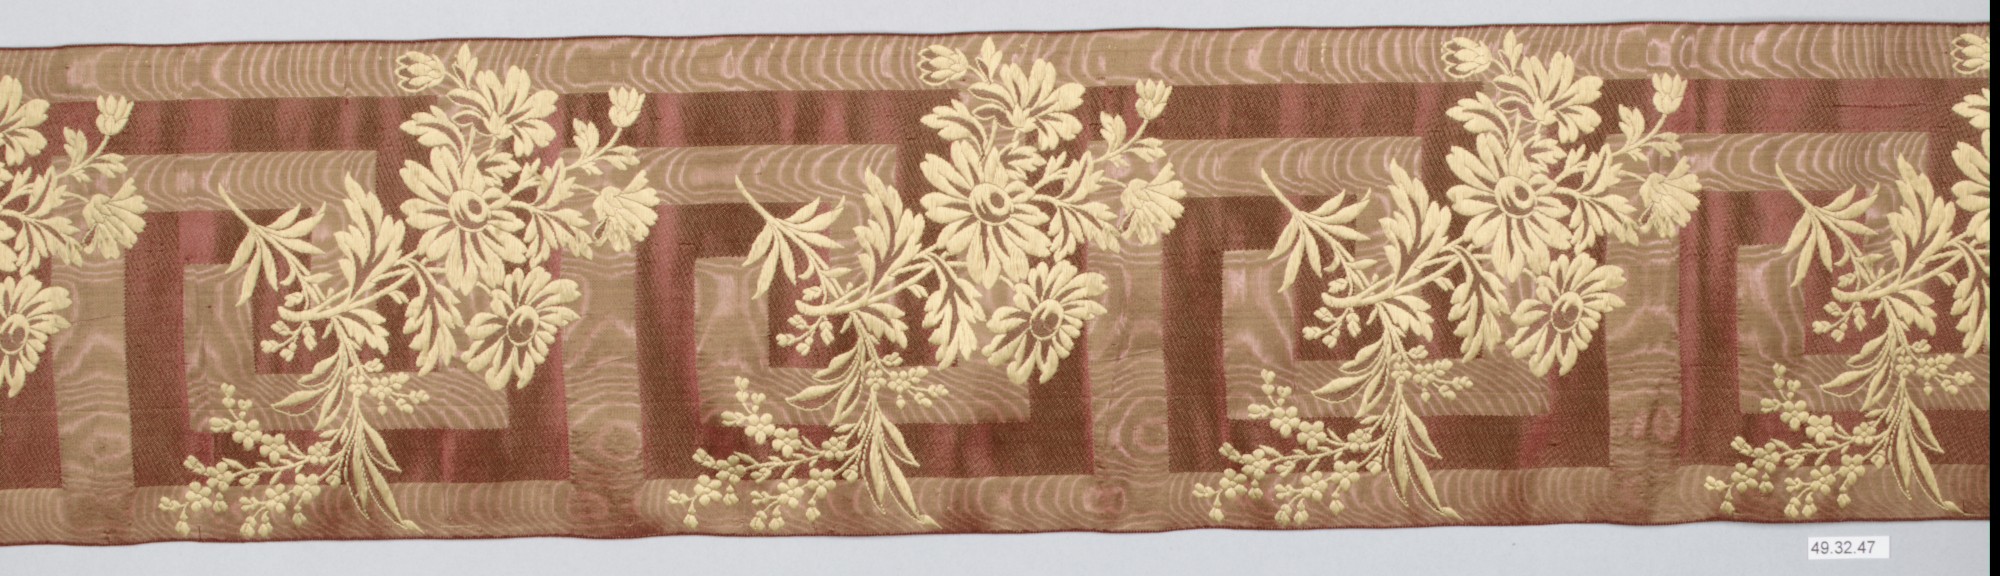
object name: ribbon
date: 1860-1870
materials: silk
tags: flowers